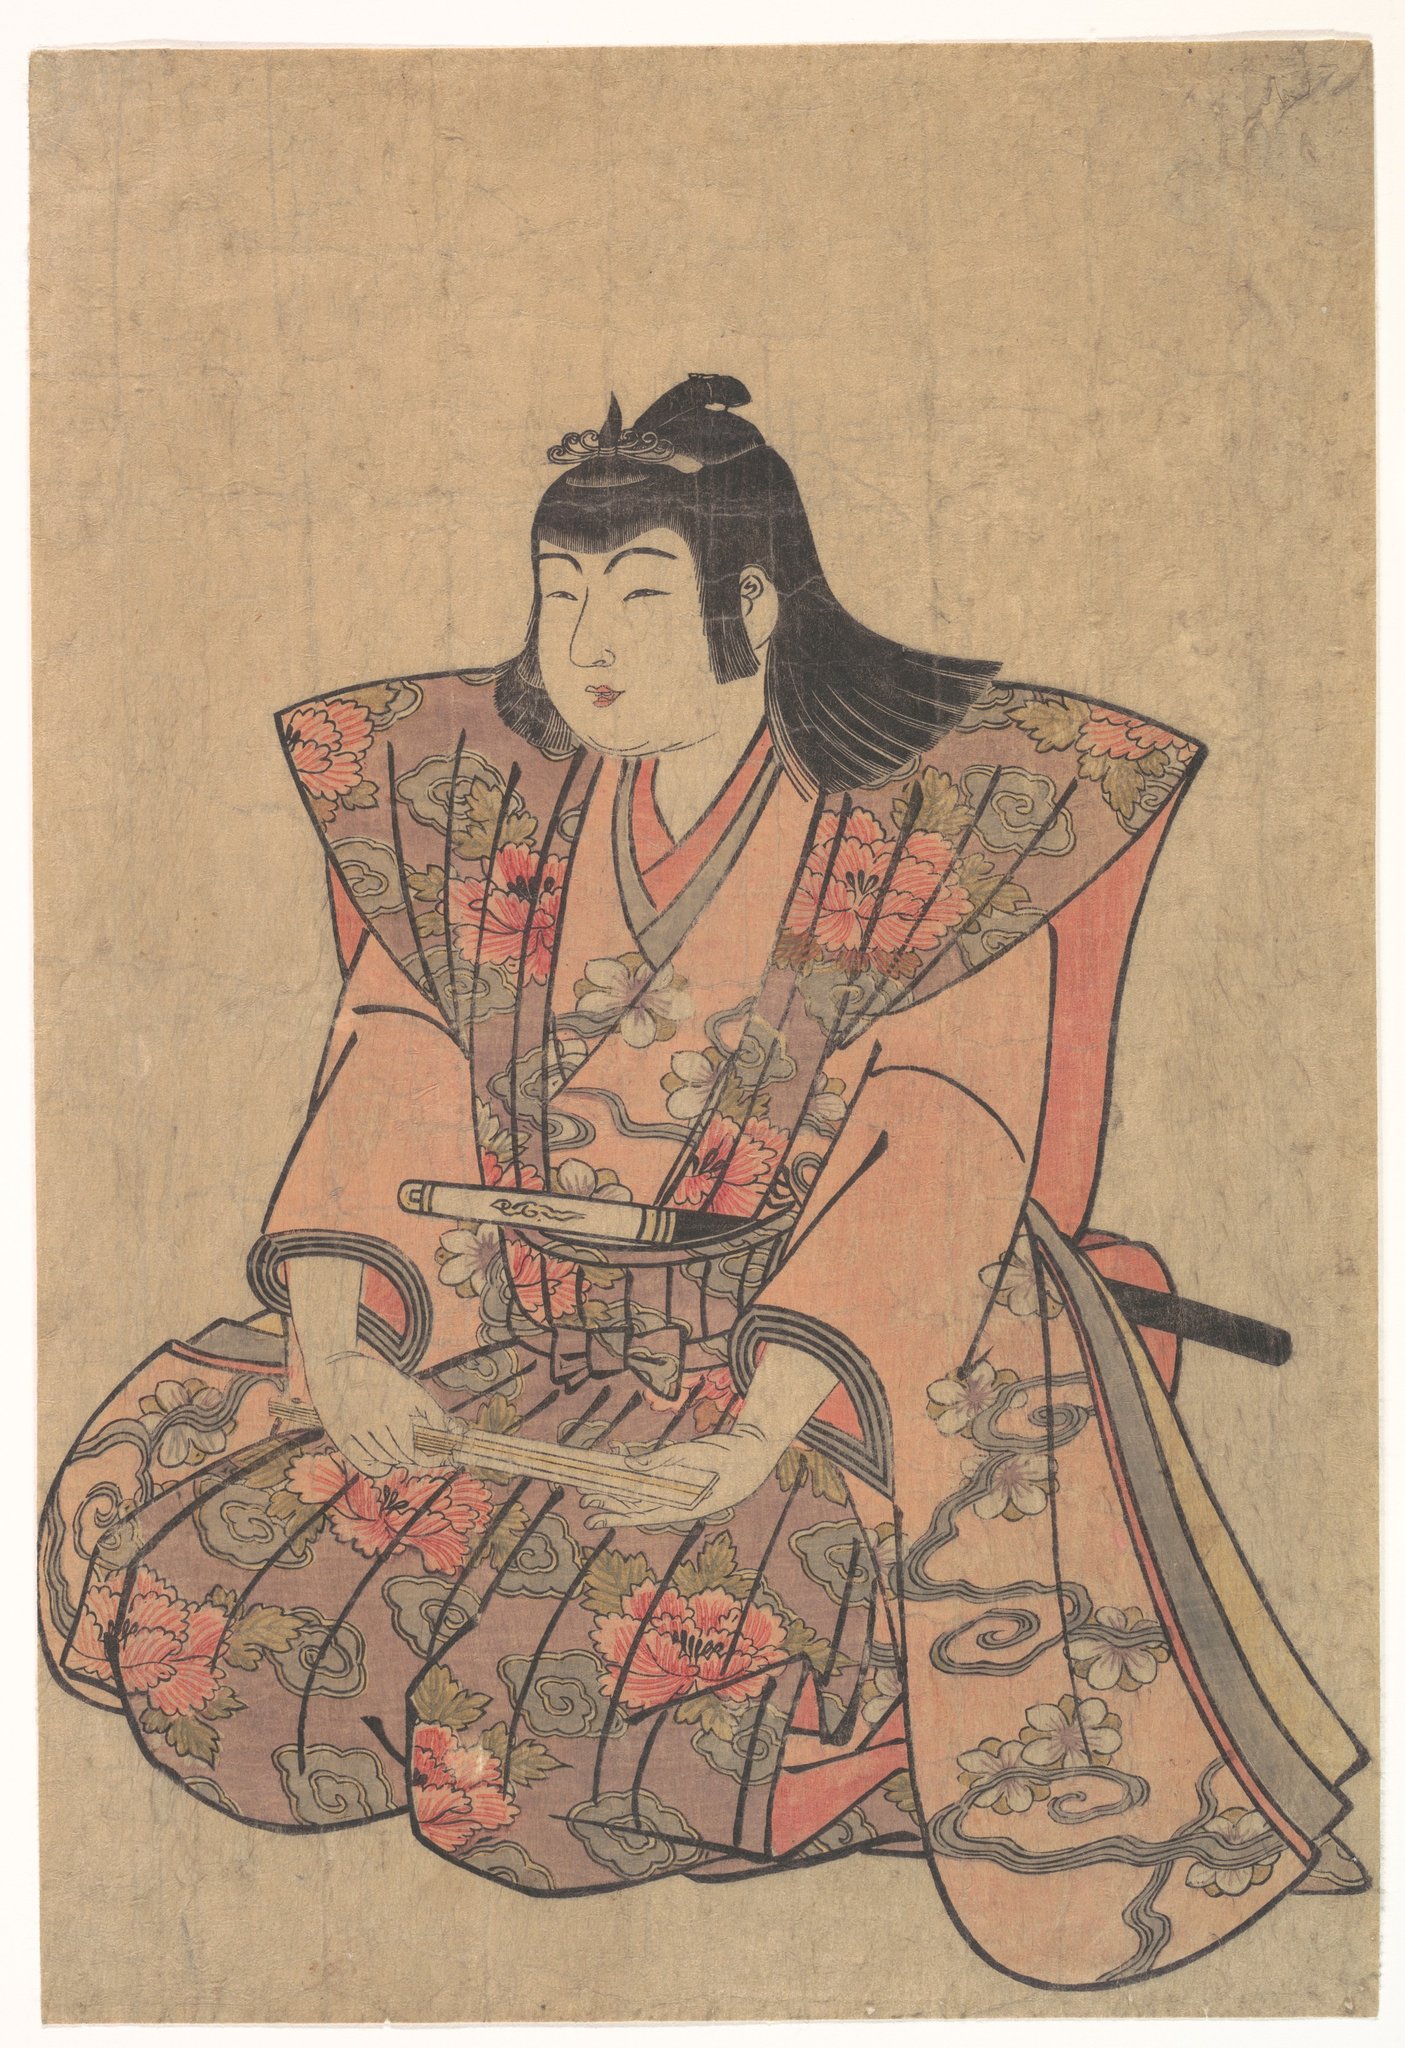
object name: print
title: A Boy Singer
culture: japanese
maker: kitao shigemasa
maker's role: artist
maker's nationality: japanese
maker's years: 1739-1820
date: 1739-1820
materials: ink, paper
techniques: woodblock print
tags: boys,singers